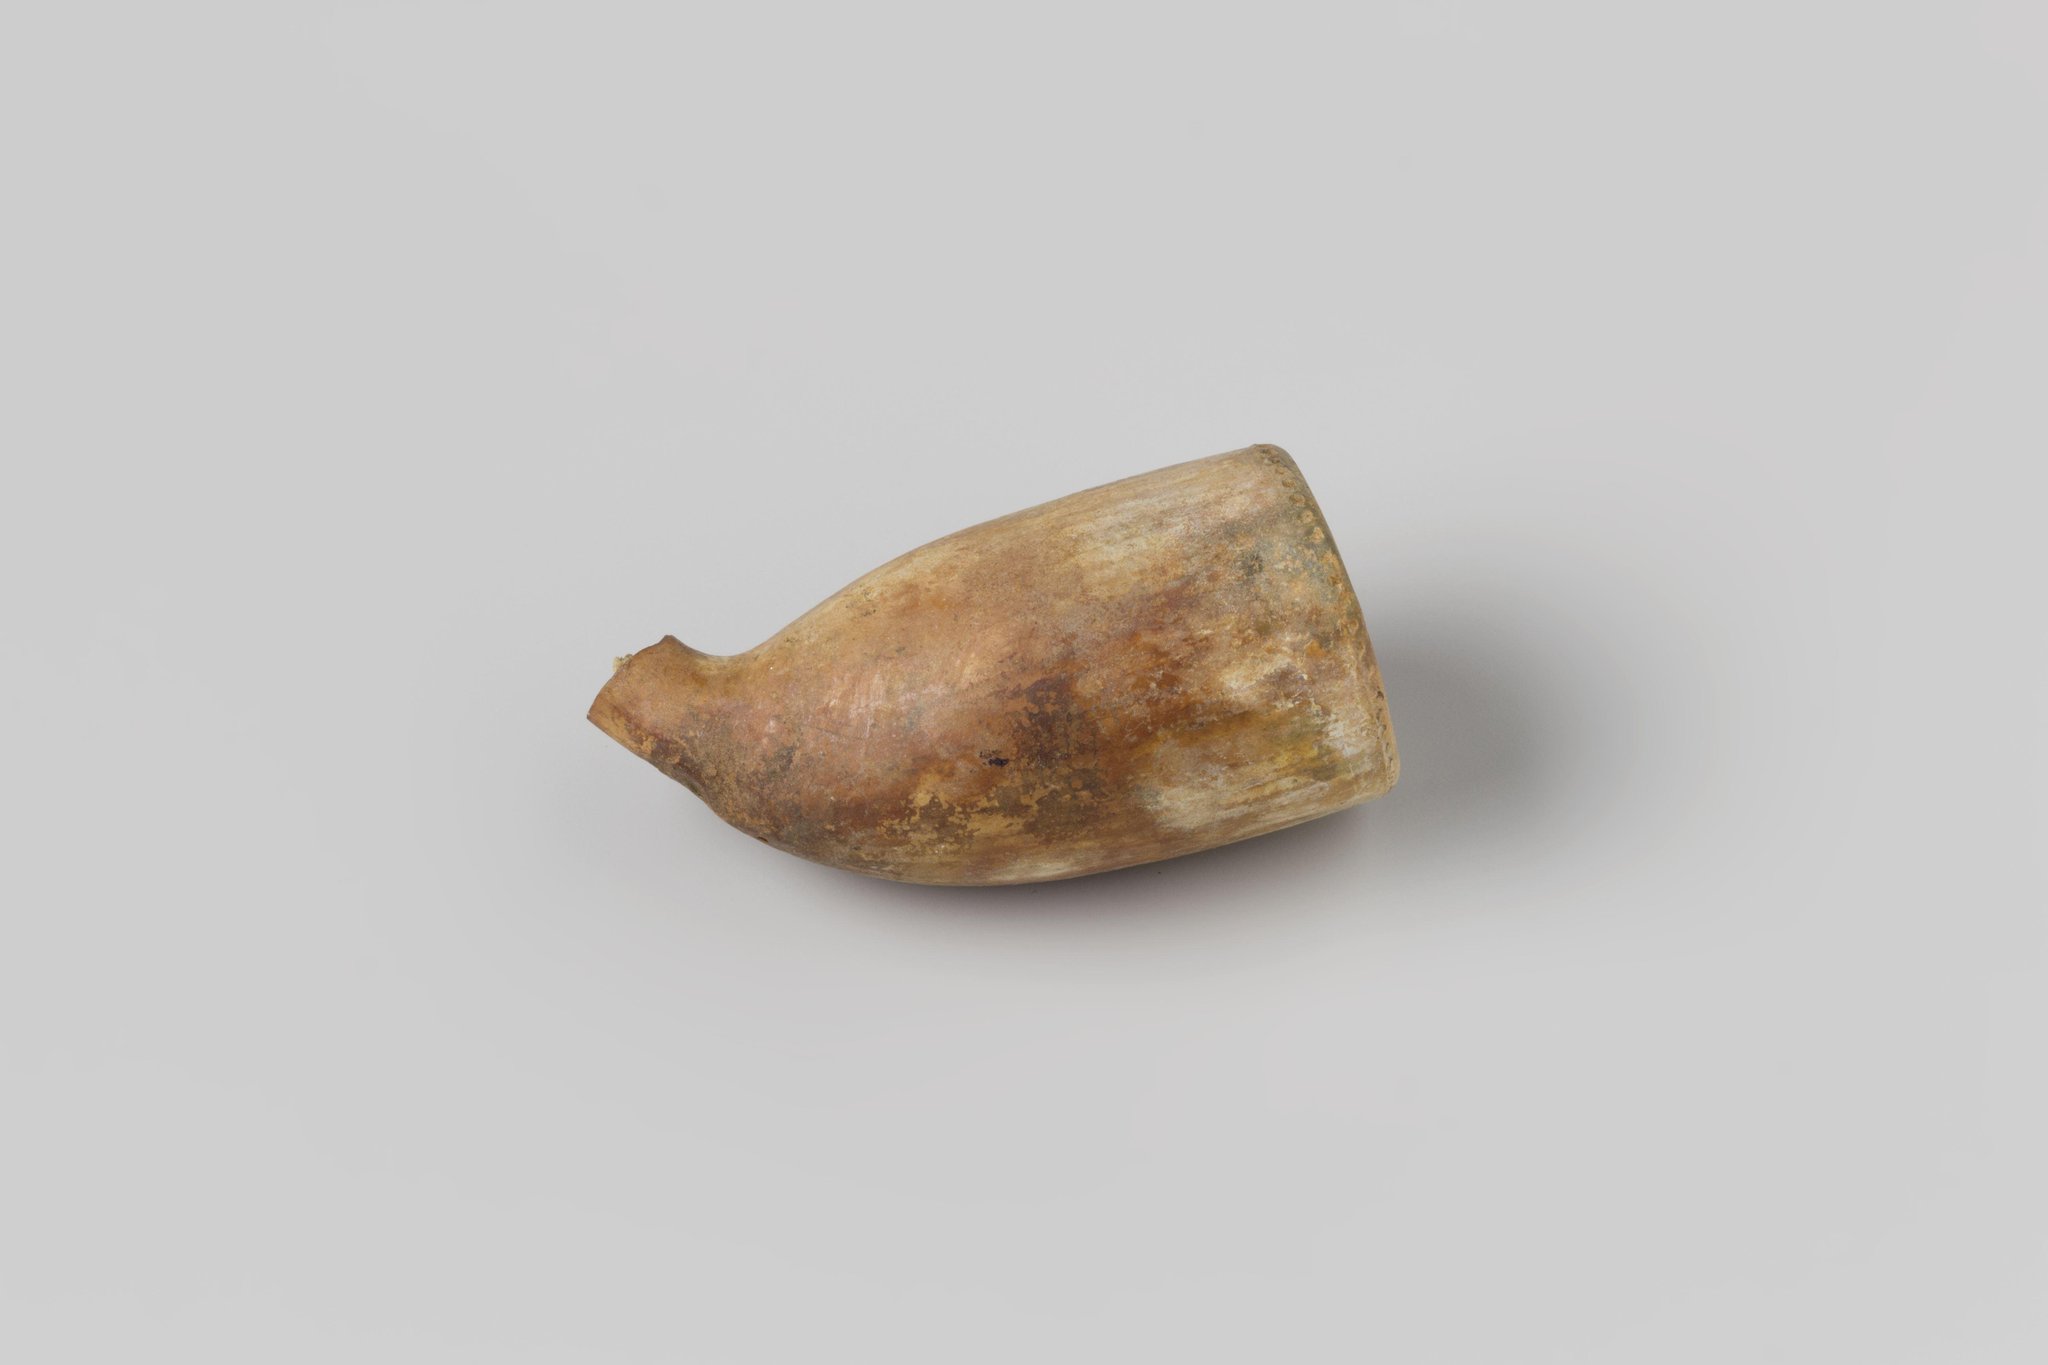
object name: pipe bowl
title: Pijpenkop uit het wrak van de Oost-Indiëvaarder Hollandia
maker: Anonymous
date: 1700-1743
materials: clay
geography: netherlands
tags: verenigde oostindische compagnie, hollandia (schip), annet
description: Pipe, bowl without heel: stamped decoration.